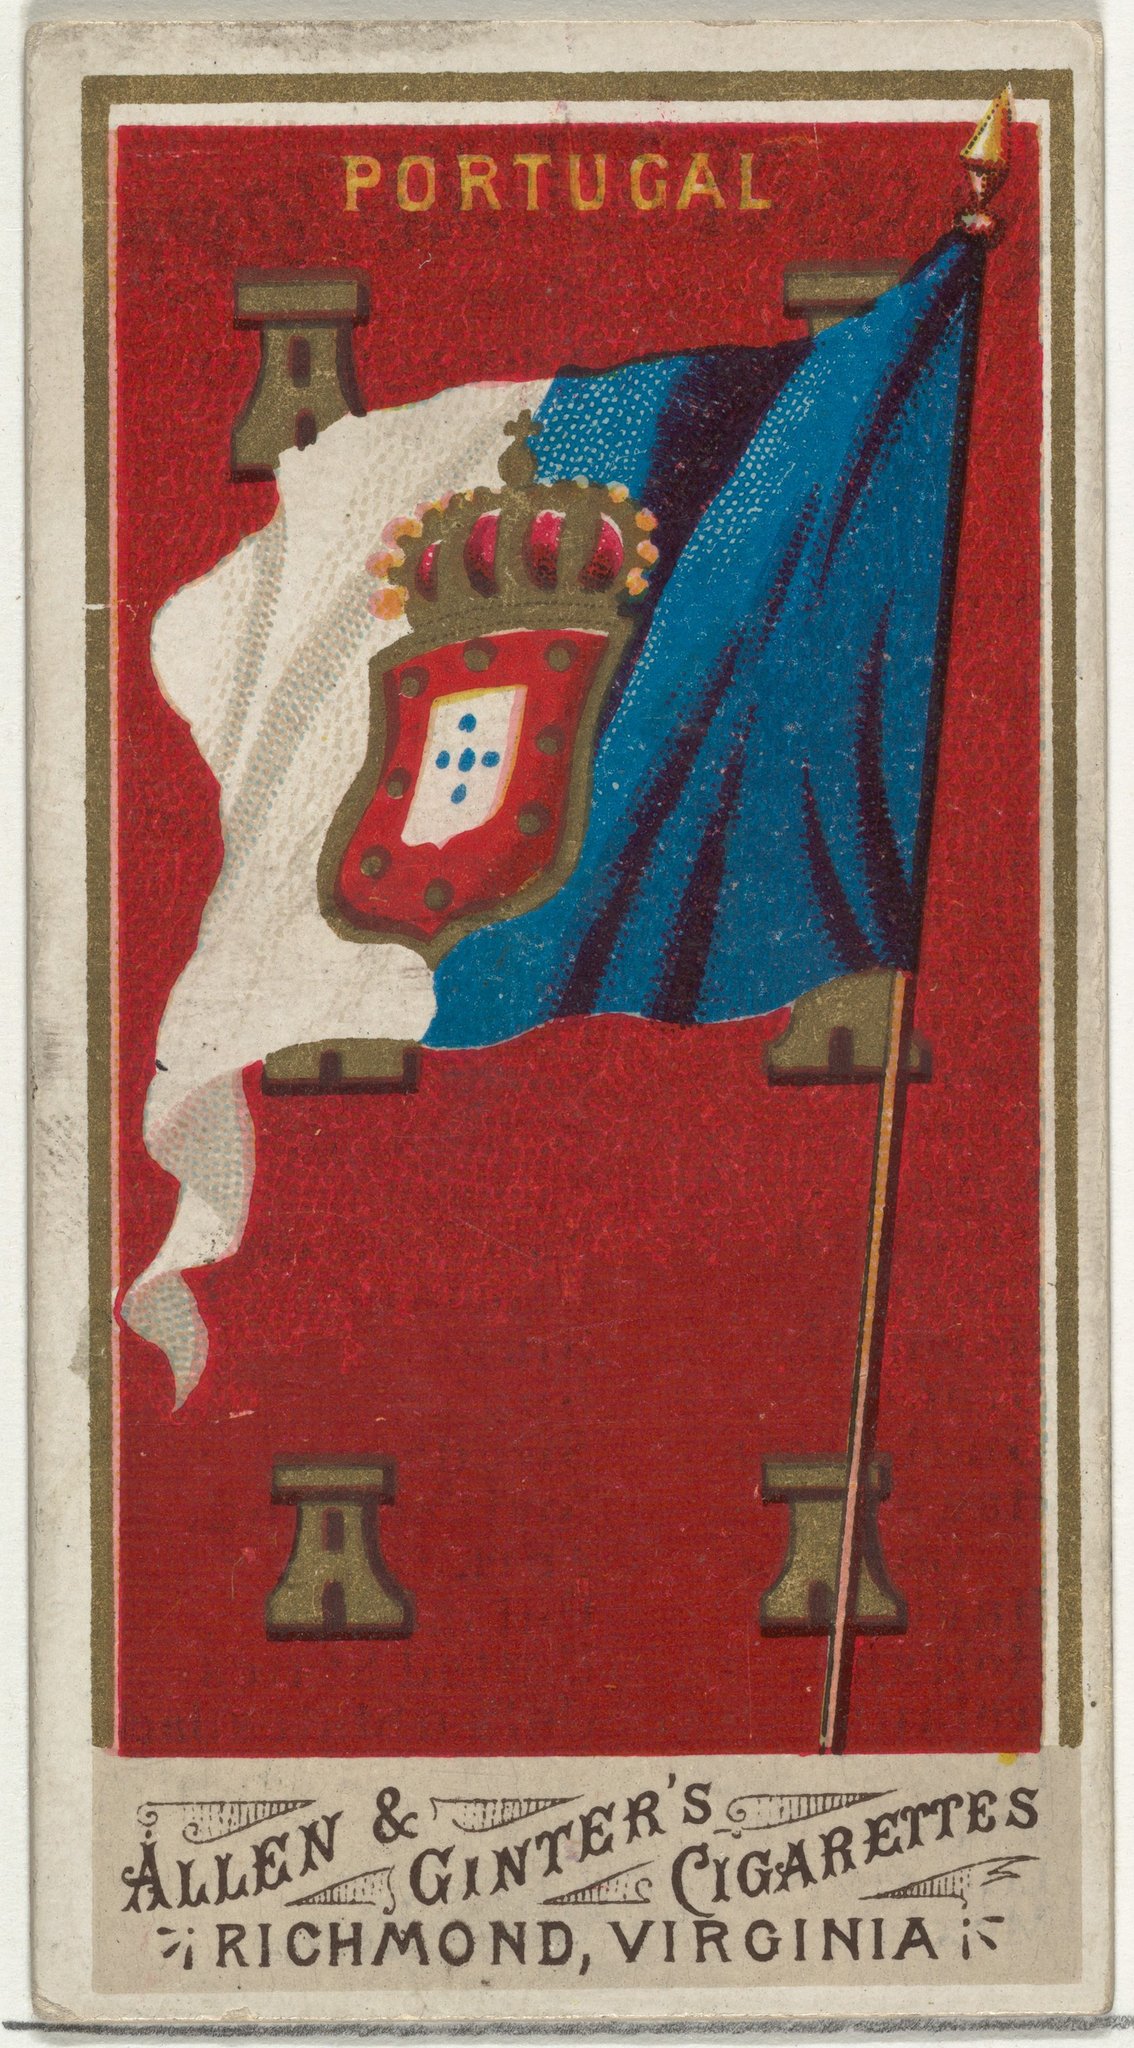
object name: print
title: Portugal, from Flags of All Nations, Series 1 (N9) for Allen & Ginter Cigarettes Brands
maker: allen & ginter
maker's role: publisher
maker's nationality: american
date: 1887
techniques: color lithograph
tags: coat of arms,flags